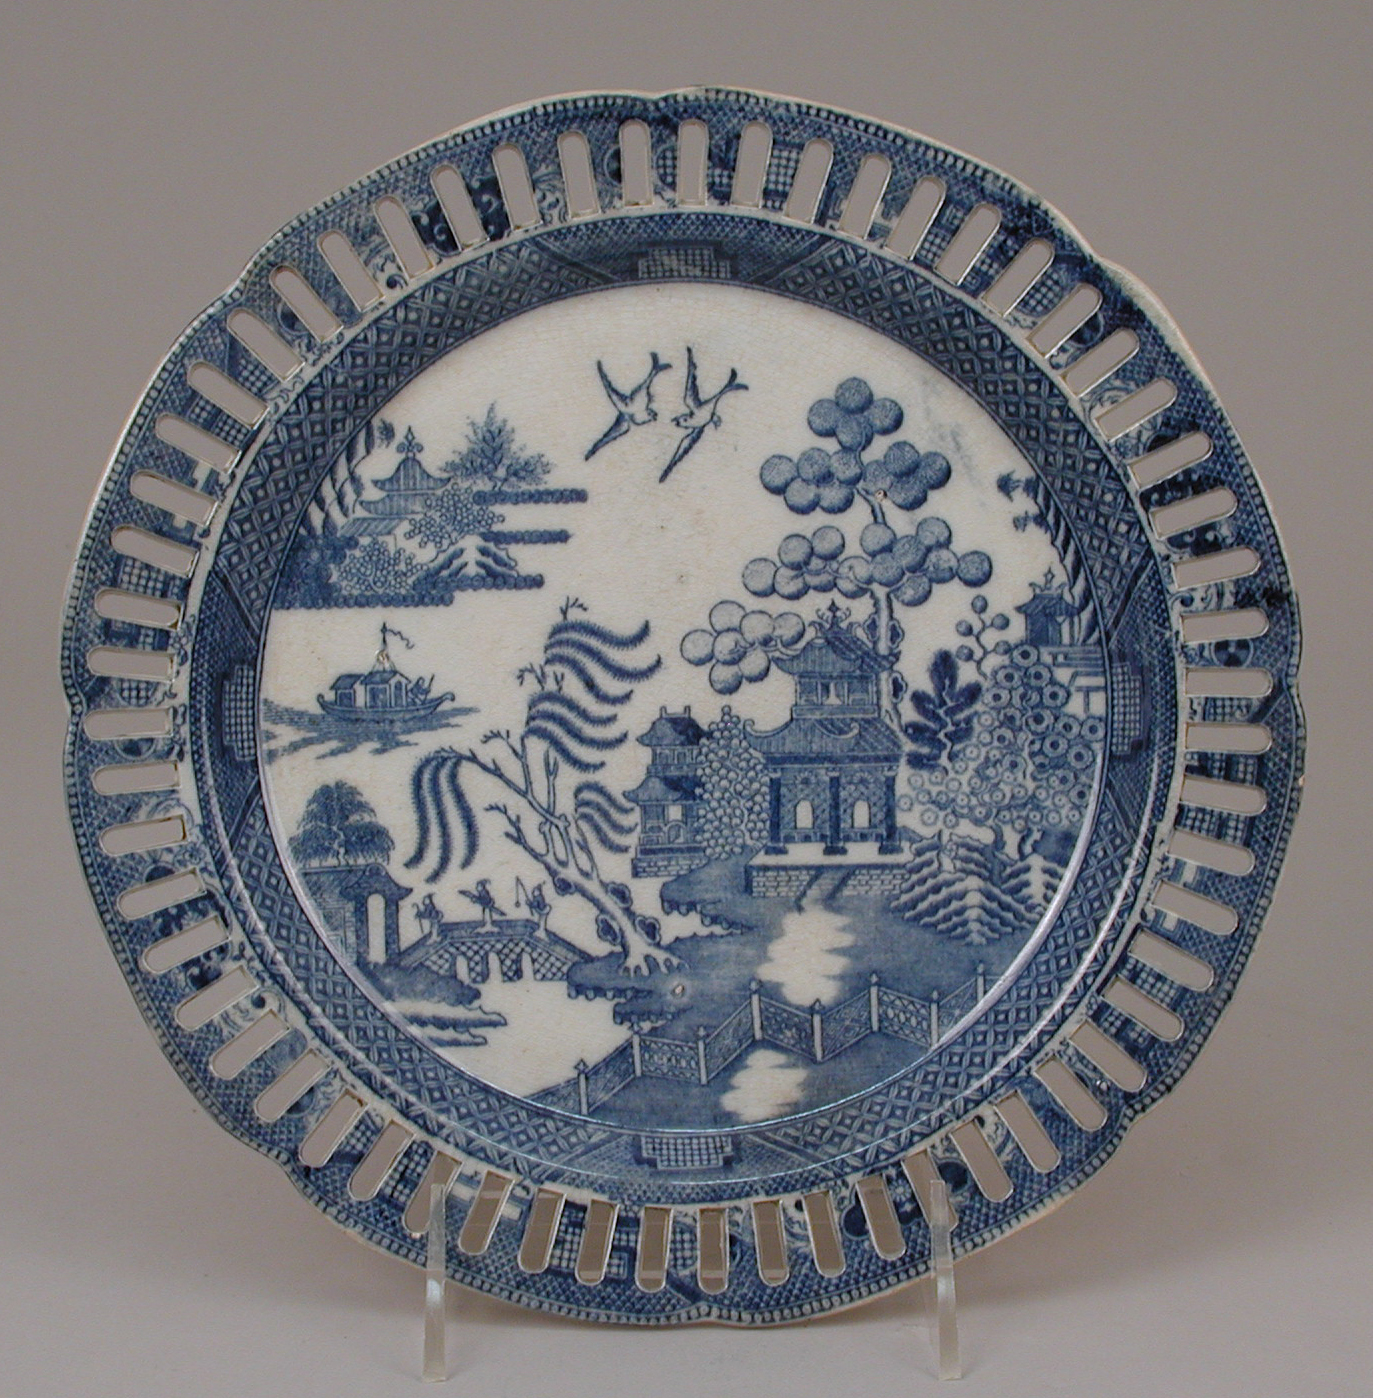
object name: plate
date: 1801-1900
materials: earthenware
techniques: transfer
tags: birds,chinoiserie,buildings